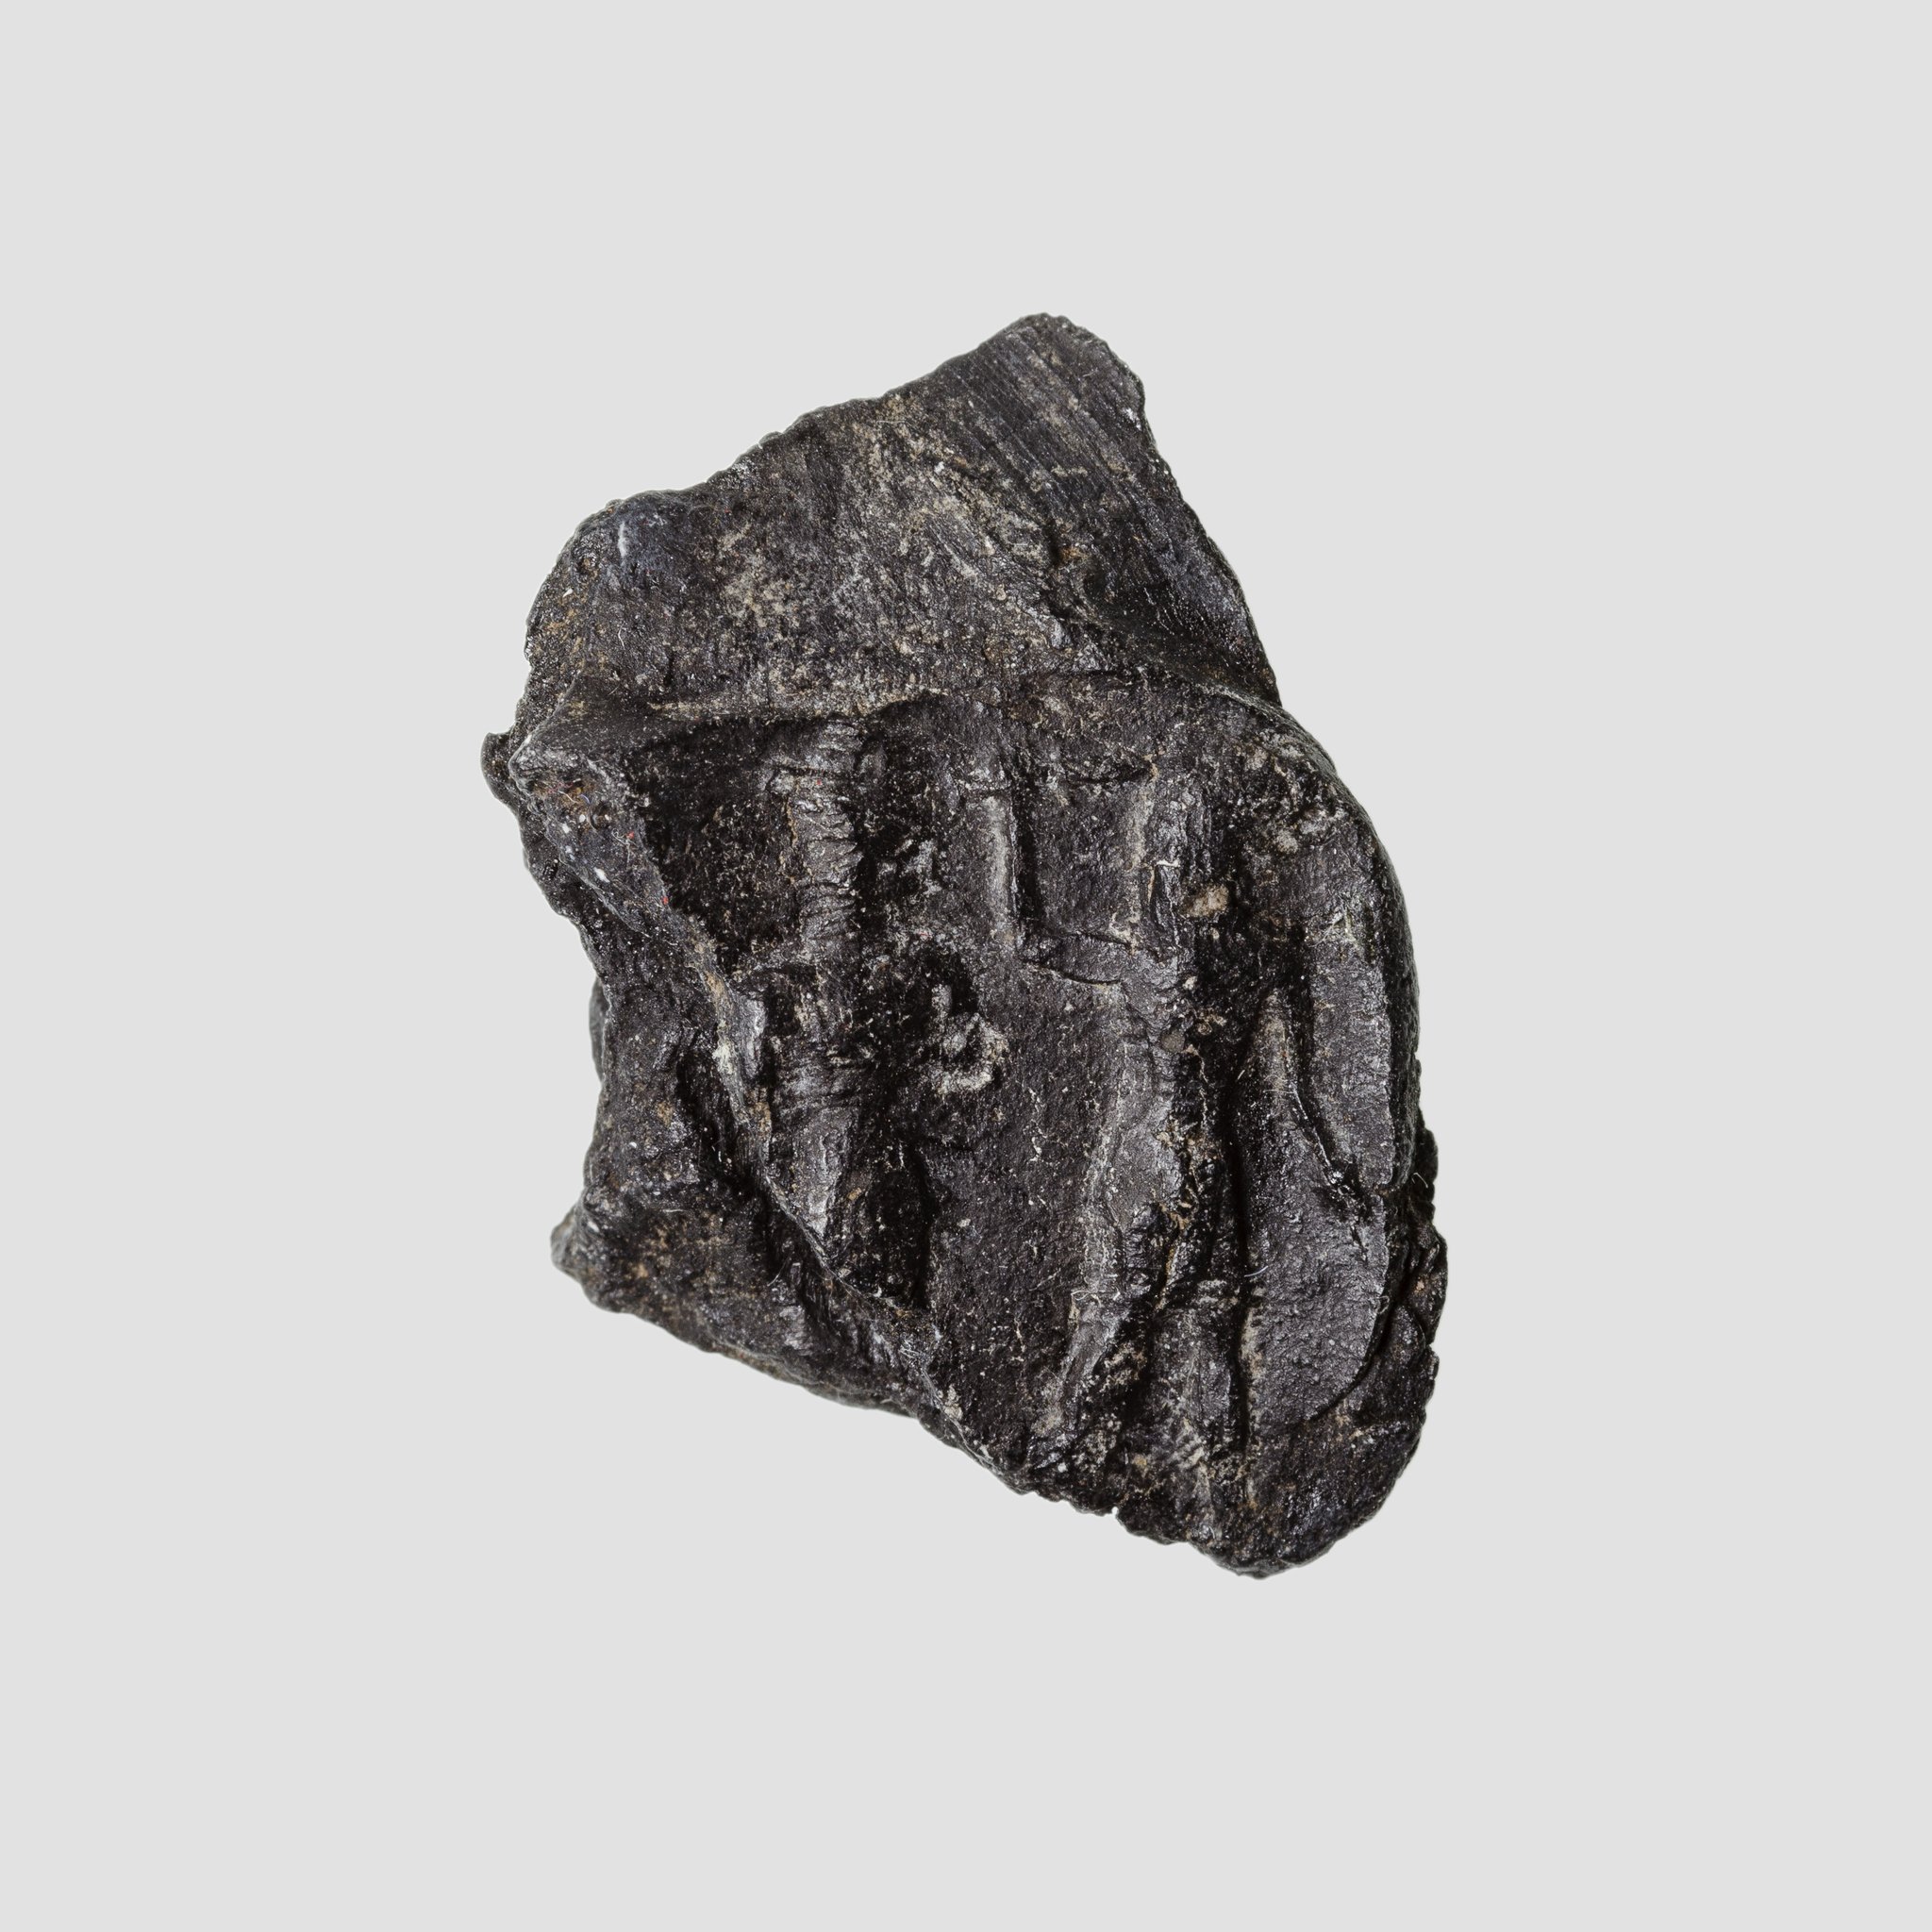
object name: cylinder seal, impression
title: Cylinder seal impression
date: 1981-1640 BCE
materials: mud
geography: egypt